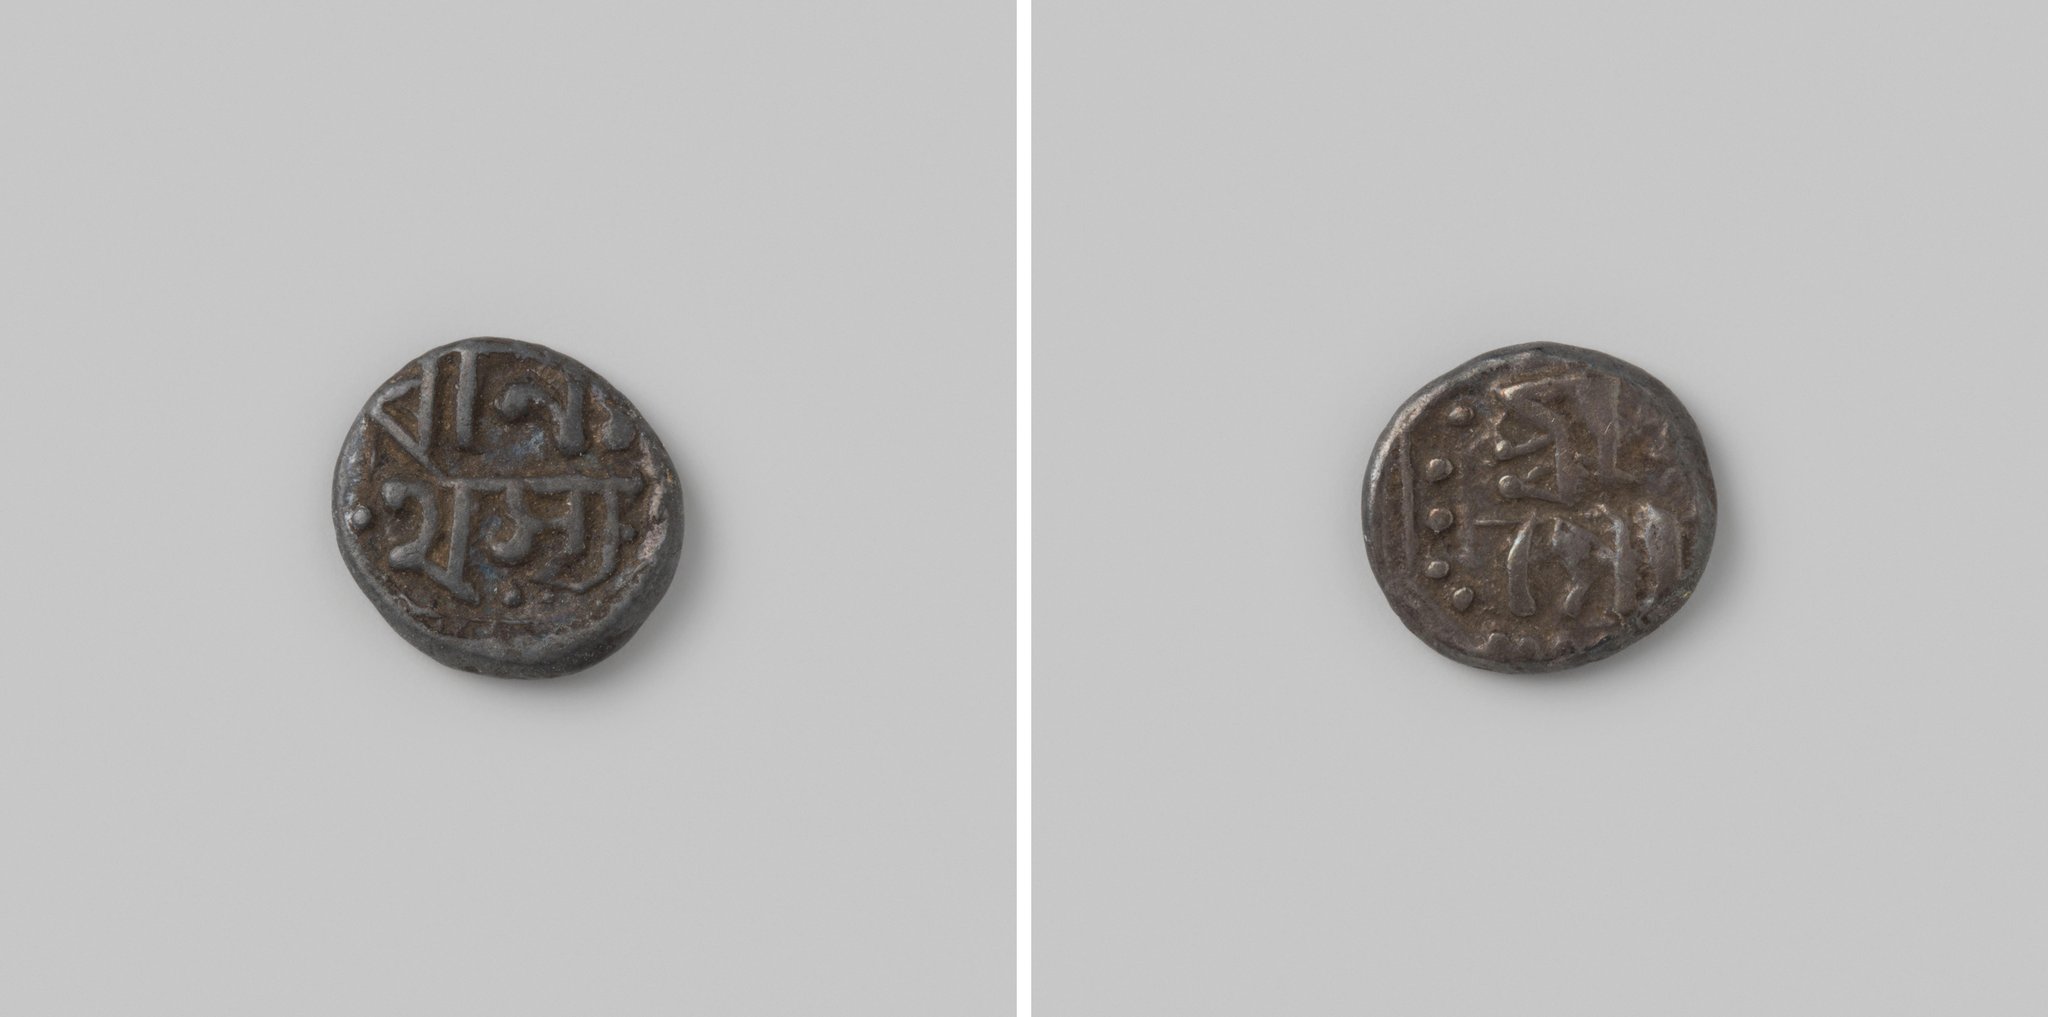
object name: coin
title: 1/32 roepie uit Assam in India van Gaurinatha Simha, 1780-1795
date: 1780-1795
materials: silver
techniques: striking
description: Zilveren munt. Voorzijde: in Nagari-schrift in twee regels naam van de vorst: Gaurinatha. Keerzijde: op twee regels onduidelijke lettertekens.